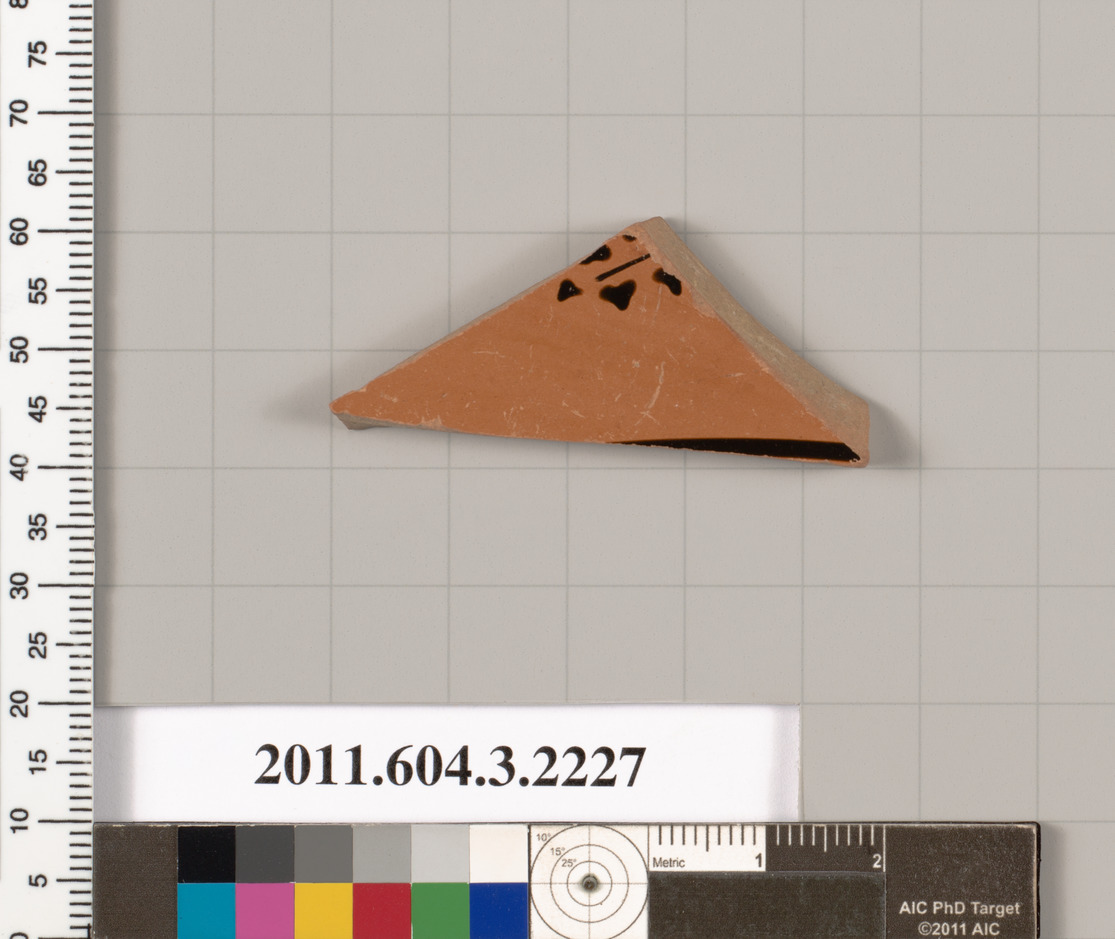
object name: kylix fragment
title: Terracotta fragment of a kylix (drinking cup)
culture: greek, attic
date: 525-501 BCE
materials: terracotta